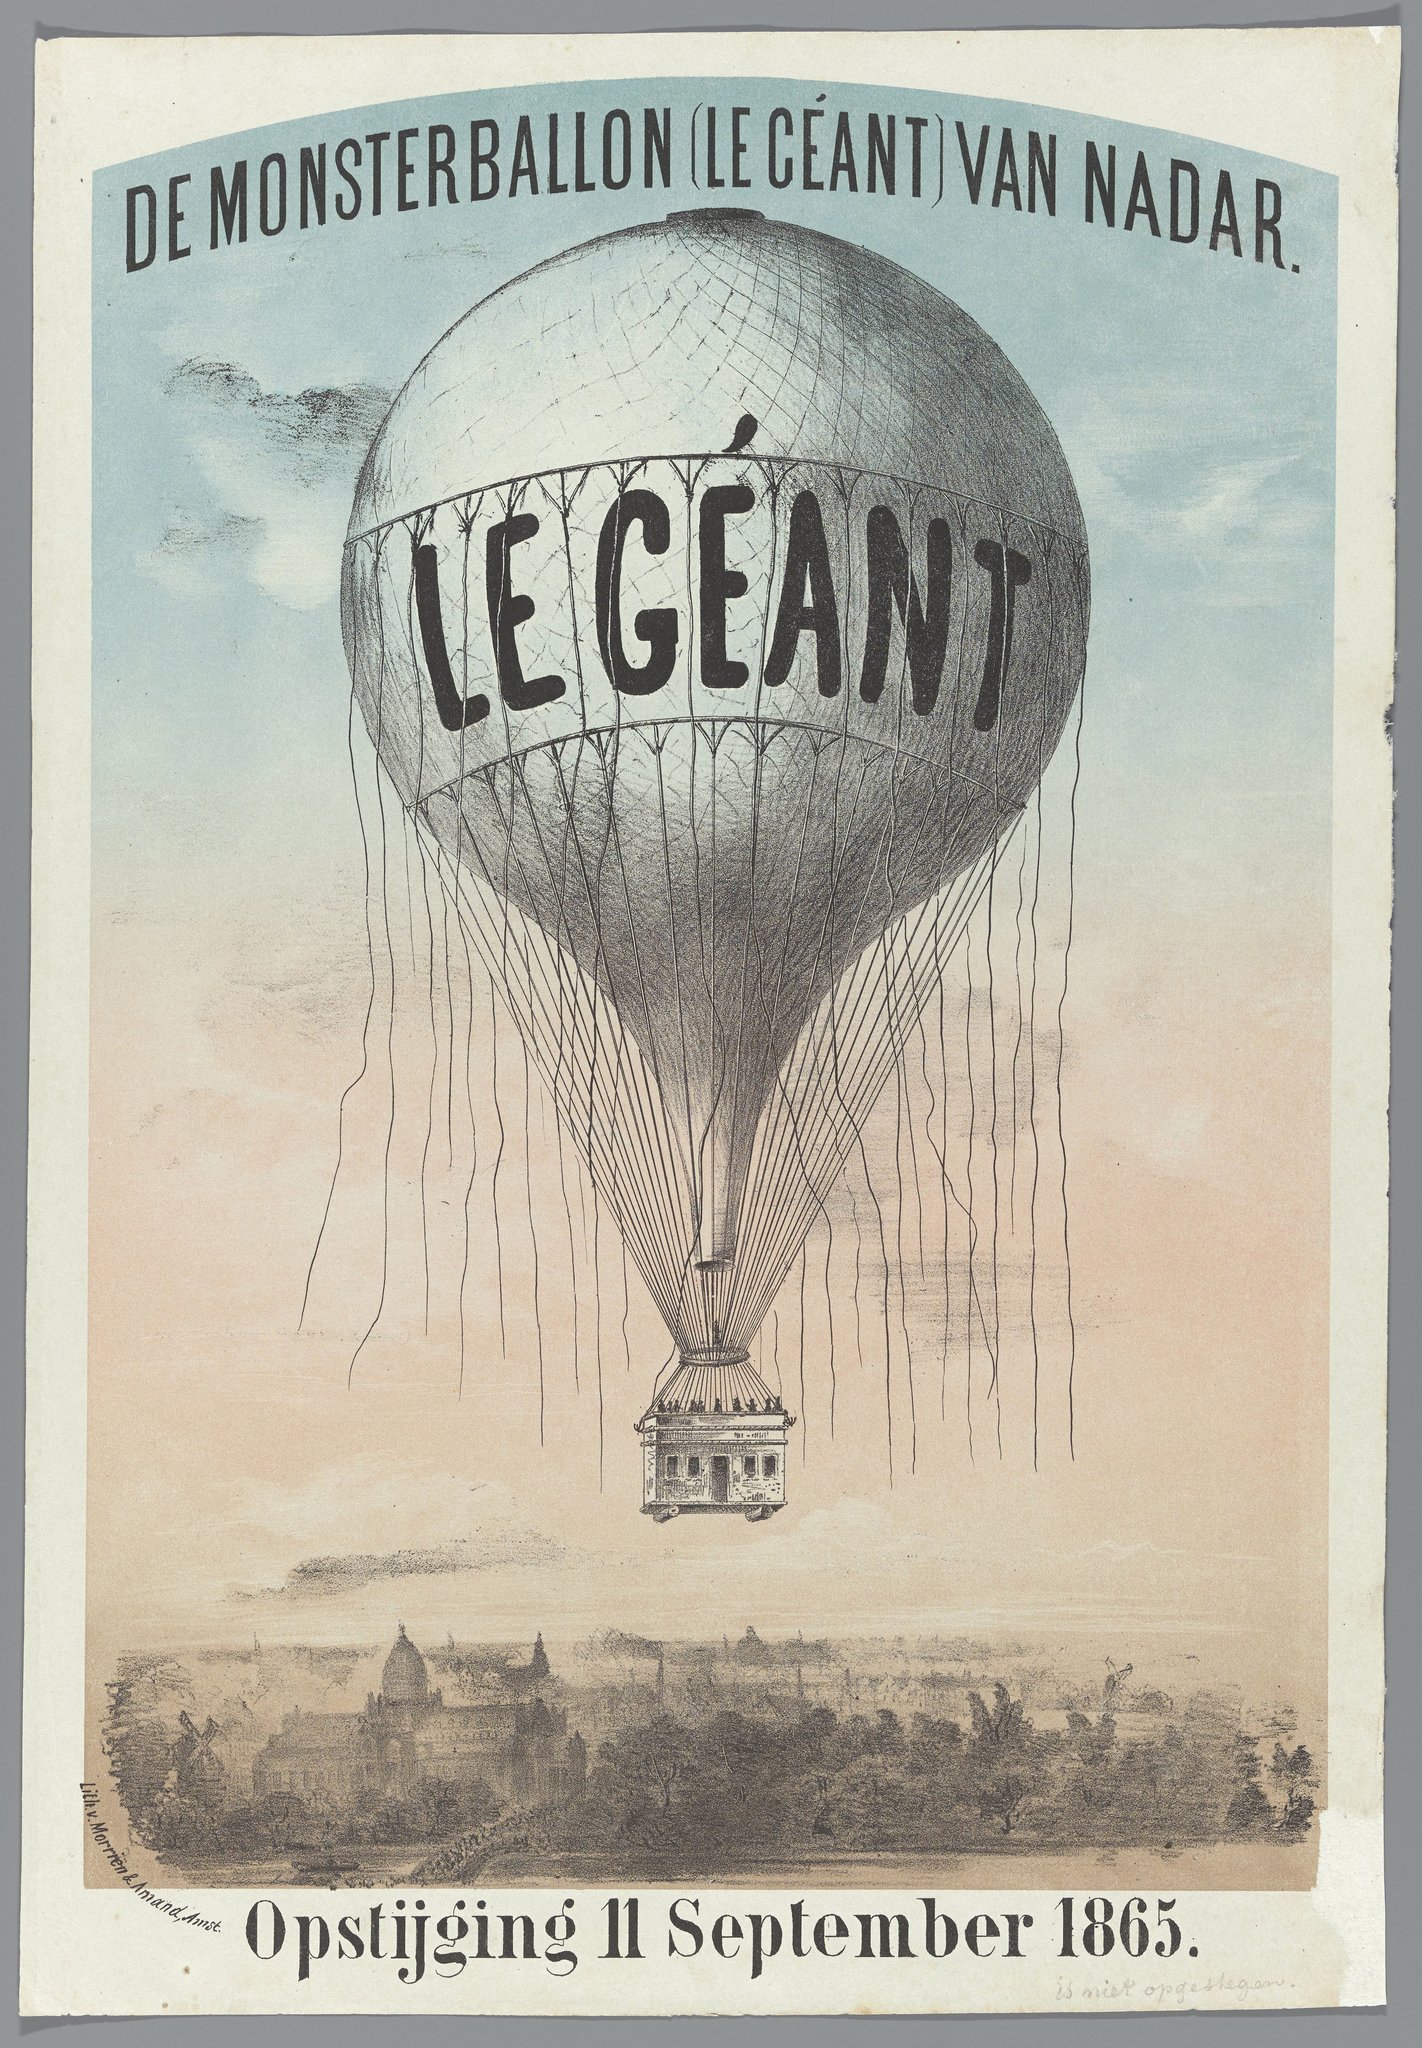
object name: print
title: De Monsterballon (Le Géant) van Nadar. Opstijging 11 September 1865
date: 1865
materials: paper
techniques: tone lithography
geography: amsterdam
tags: paris, félix nadar, balloon flight (sport), balloon (aviation), amsterdam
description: De luchtballon van Nadar (Félix Tournachon) genaamd 'Le Géant' die in september 1865 tentoongesteld is in het Paleis van Volksvlijt te Amsterdam. De luchtballon is uiteindelijk niet op 11 maar op 14 september opgelaten op een weiland ten zuiden van de Singelgracht. Plaat in een omslag met een tekstblad met bijzonderheden.